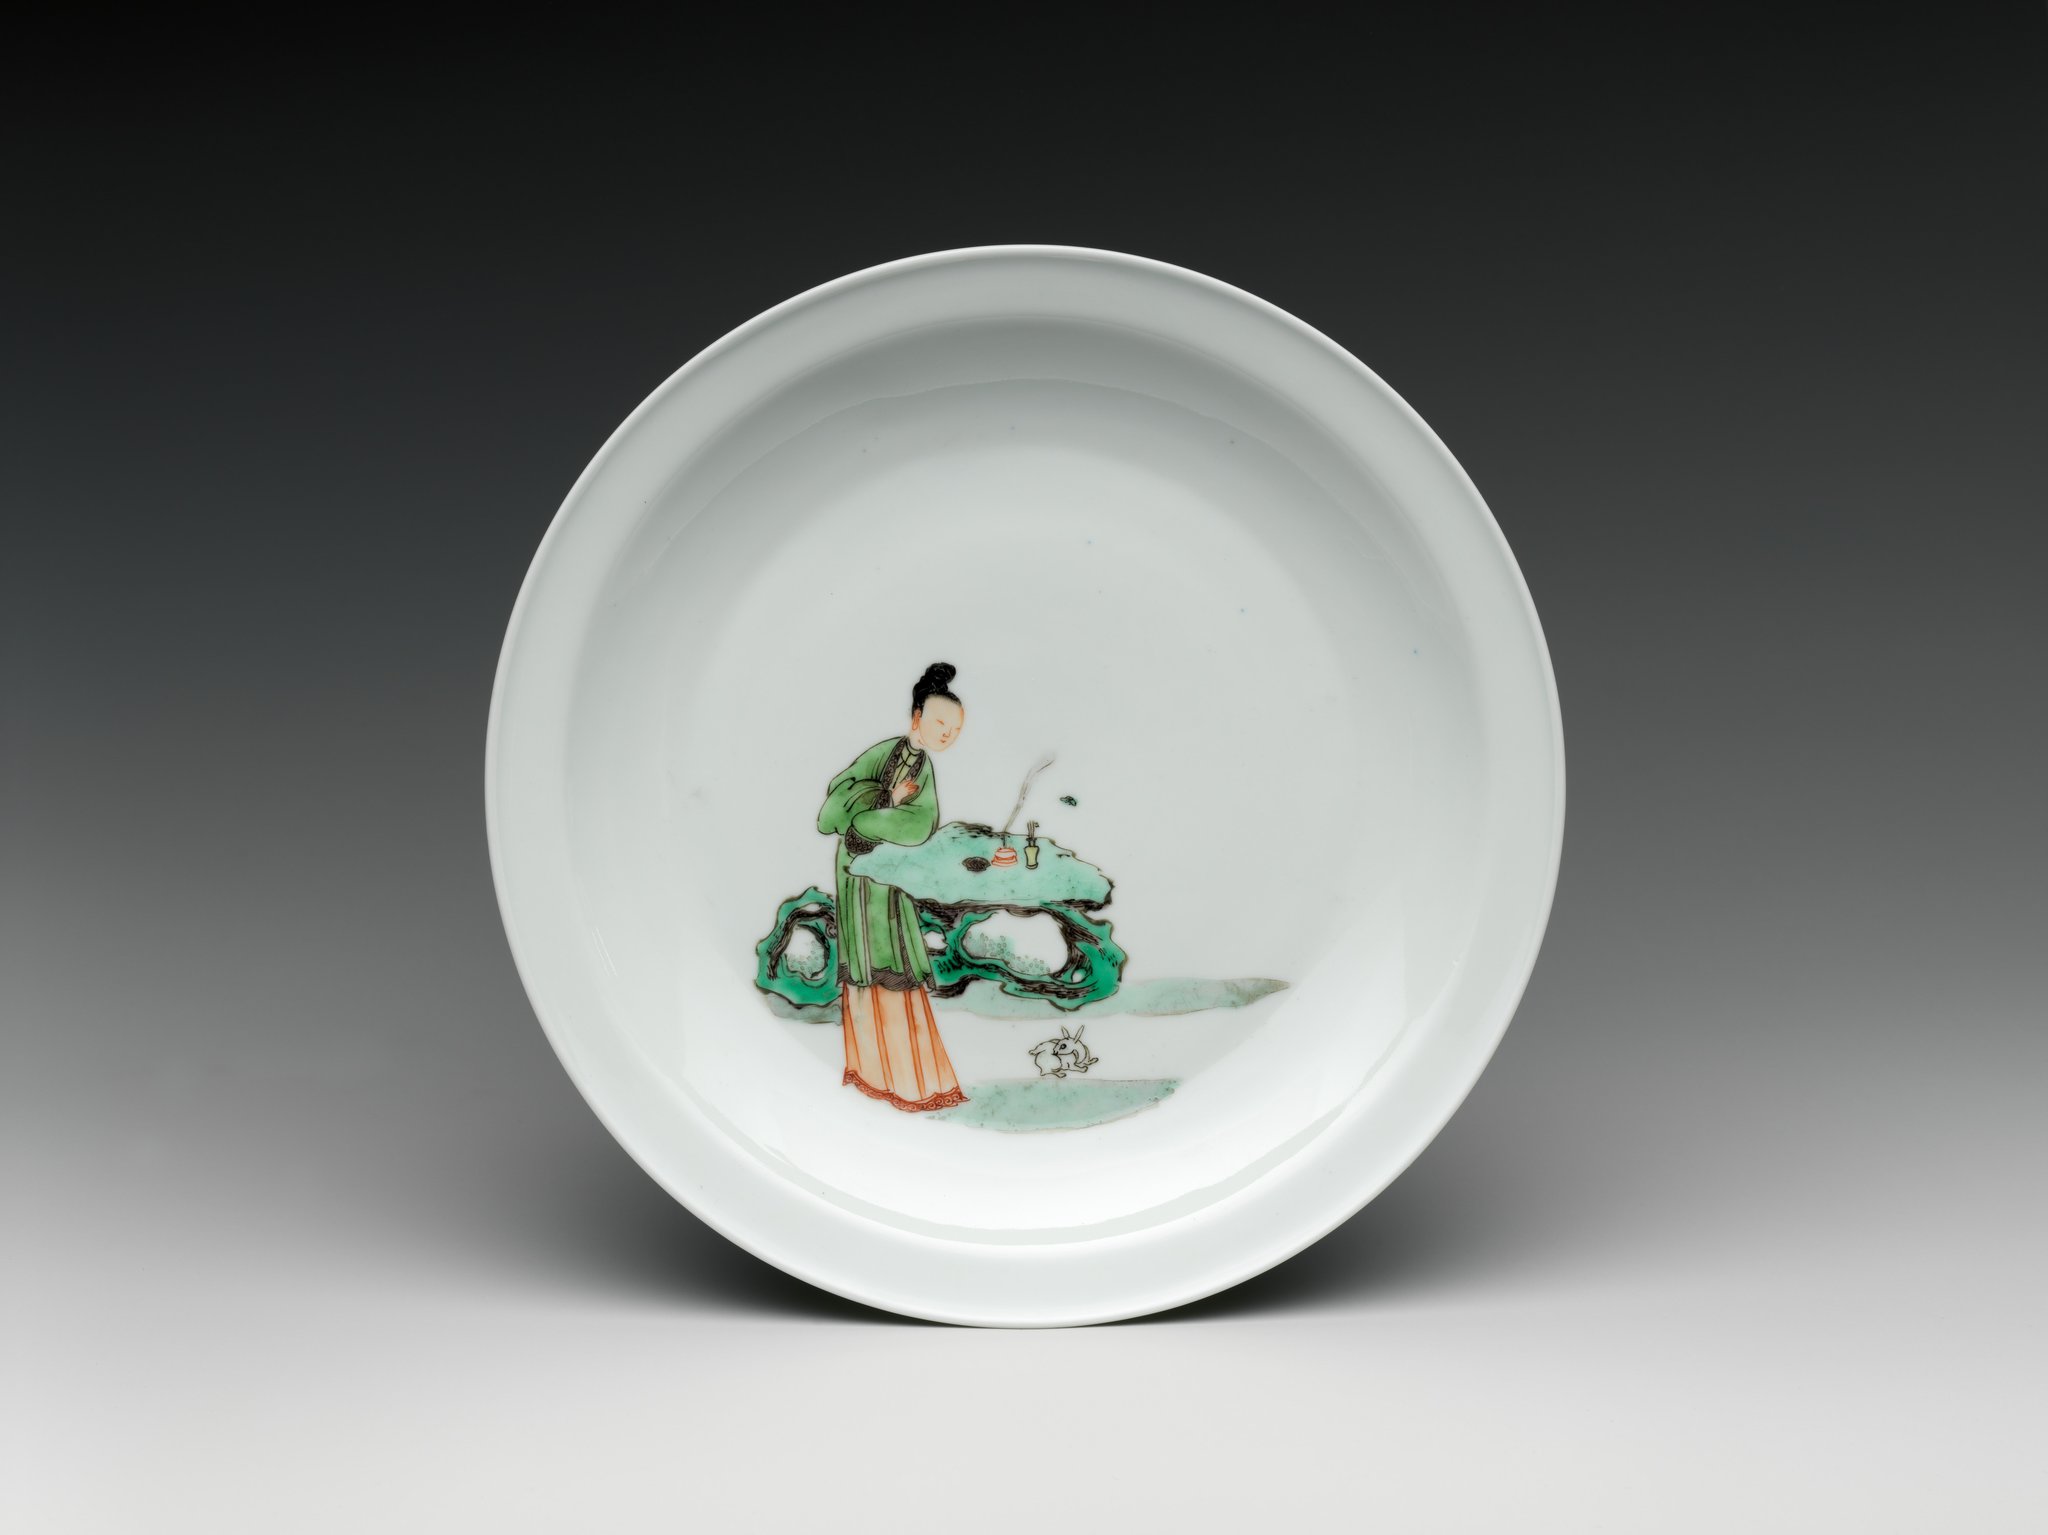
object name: dish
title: Dish with woman and rabbit in a garden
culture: chinese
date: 1701-1733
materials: enamel, porcelain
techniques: overglaze, painting, polychrome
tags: women,rabbits